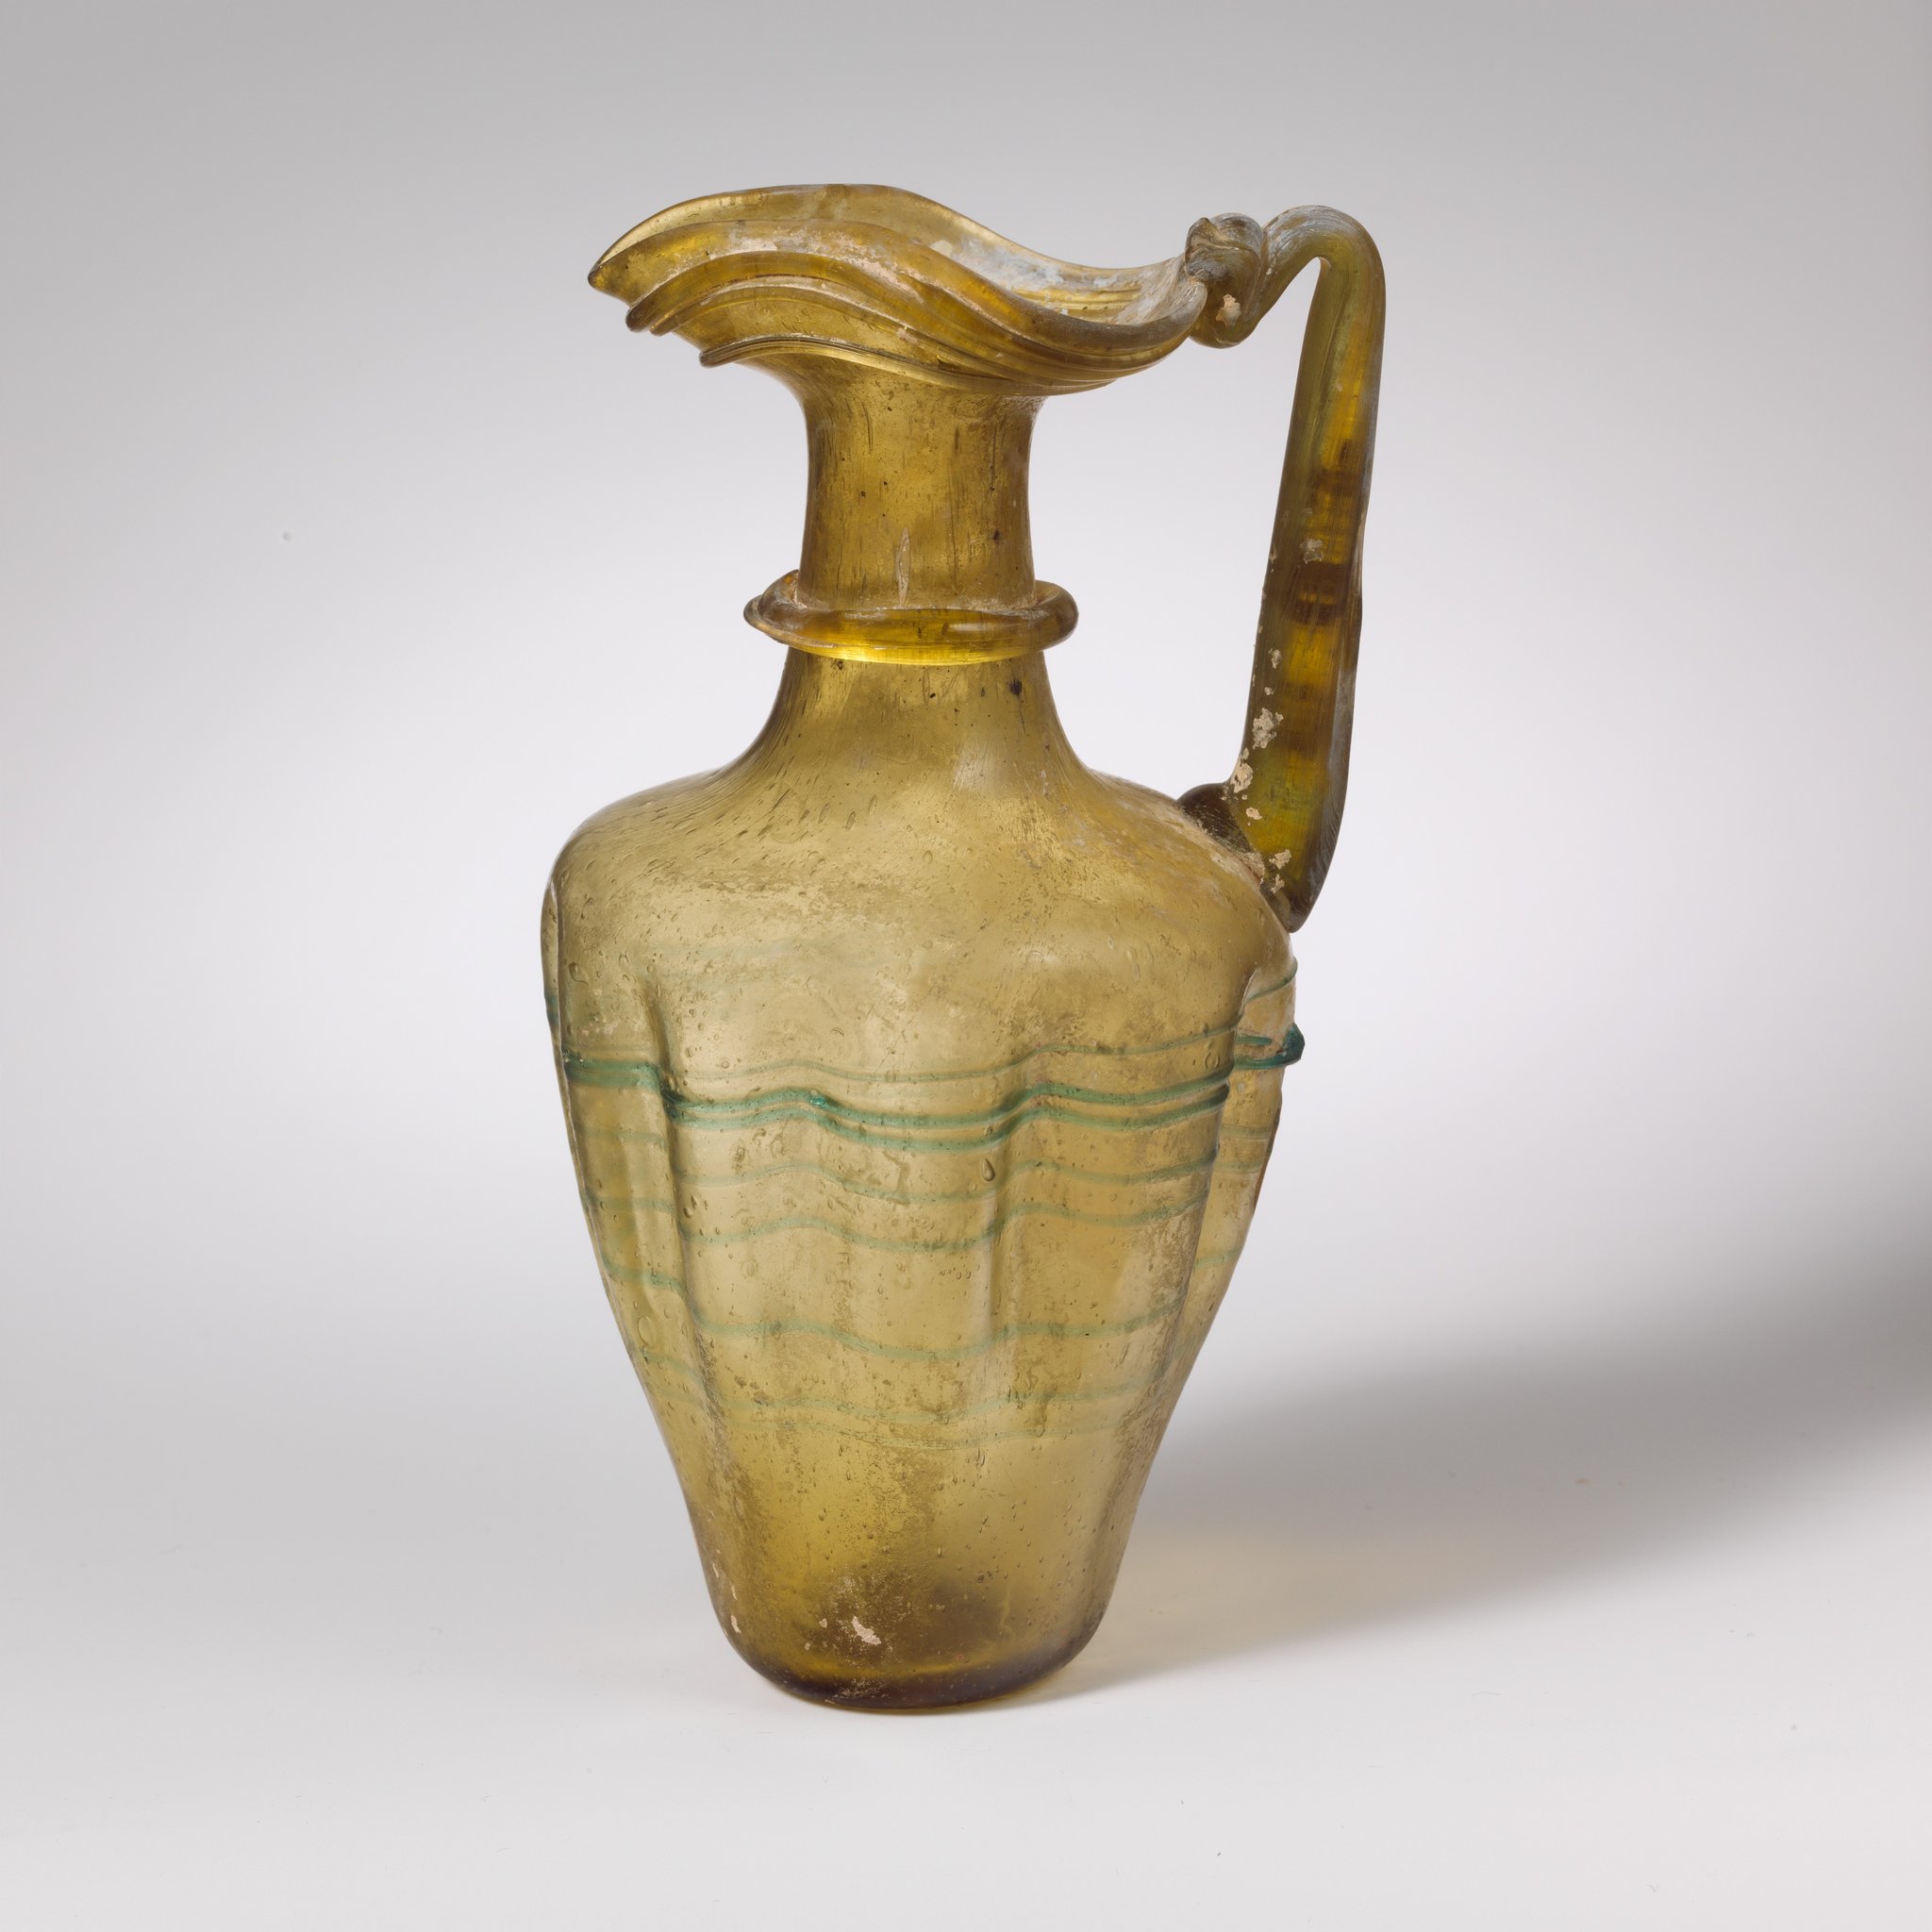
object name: jug with trefoil rim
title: Glass jug with trefoil rim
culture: roman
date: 301-500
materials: glass